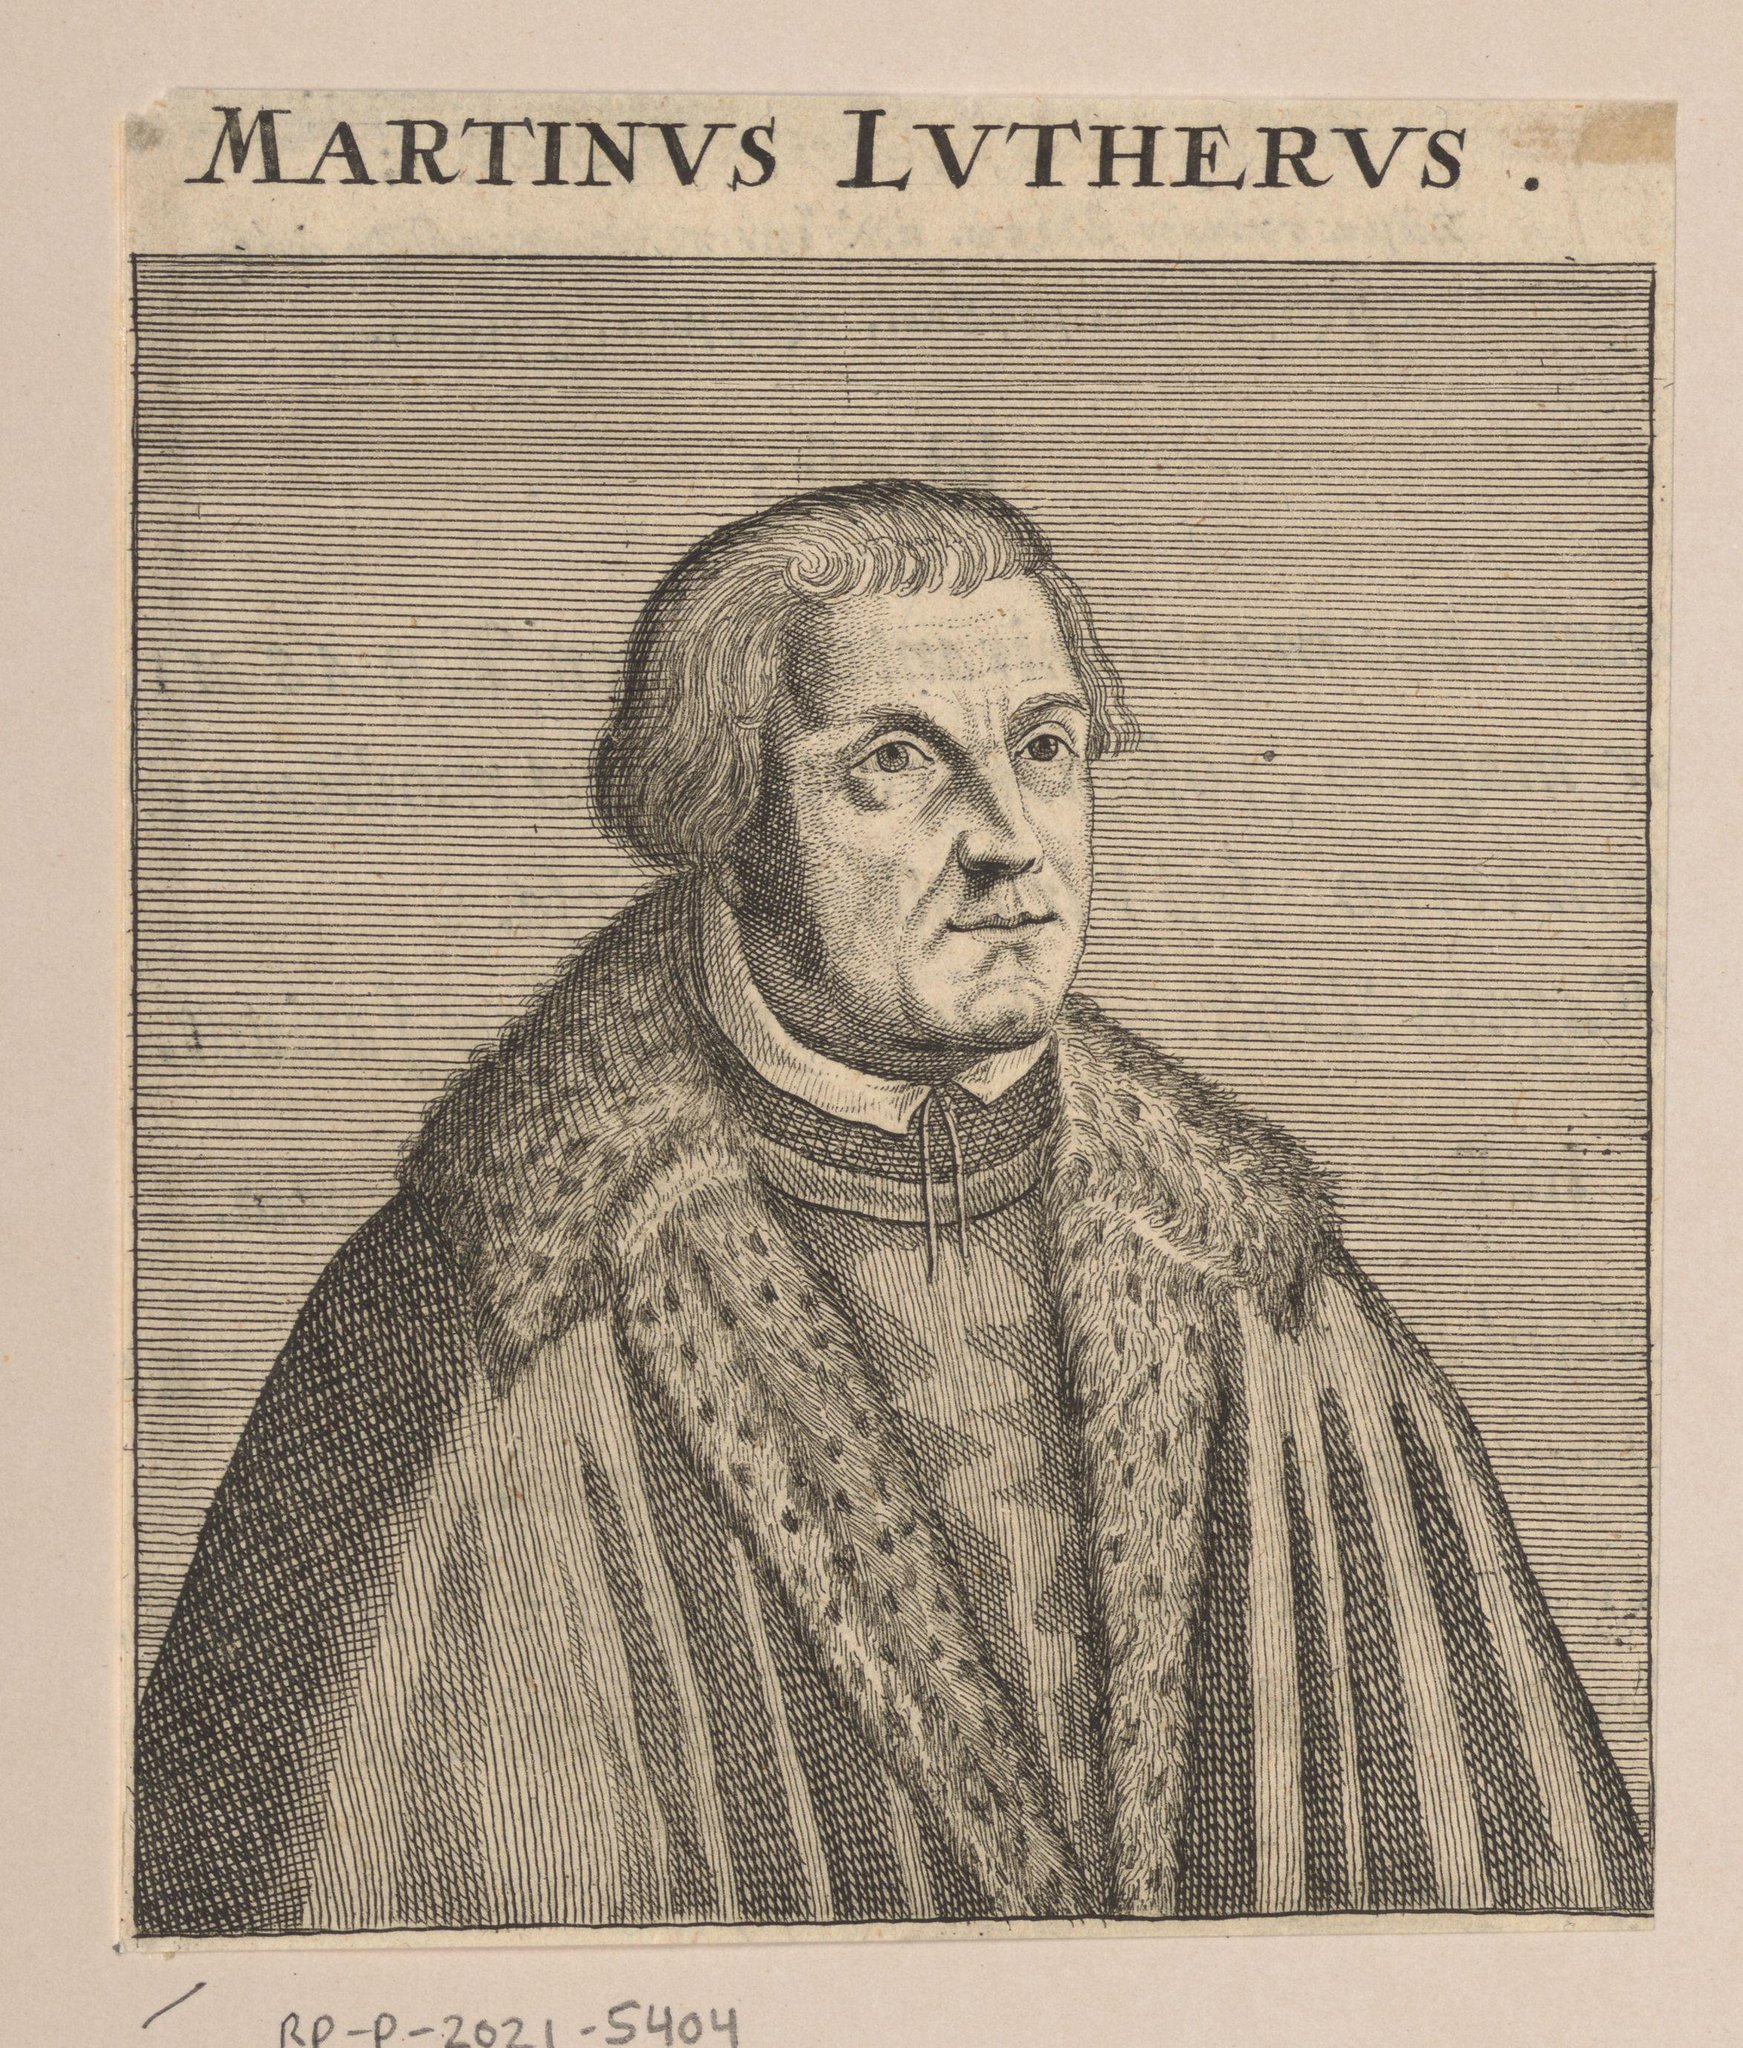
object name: book illustration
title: Portret van Martin Luther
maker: Anonymous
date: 1725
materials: paper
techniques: engraving, etching, letterpress printing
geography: germany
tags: martin luther, theologian, historical persons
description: Prent uit: Verheiden, Jacobus. Imagines et elogia praestantium aliqvot theologorum. Neurenberg: erven Johann Daniel Tauber, 1725.